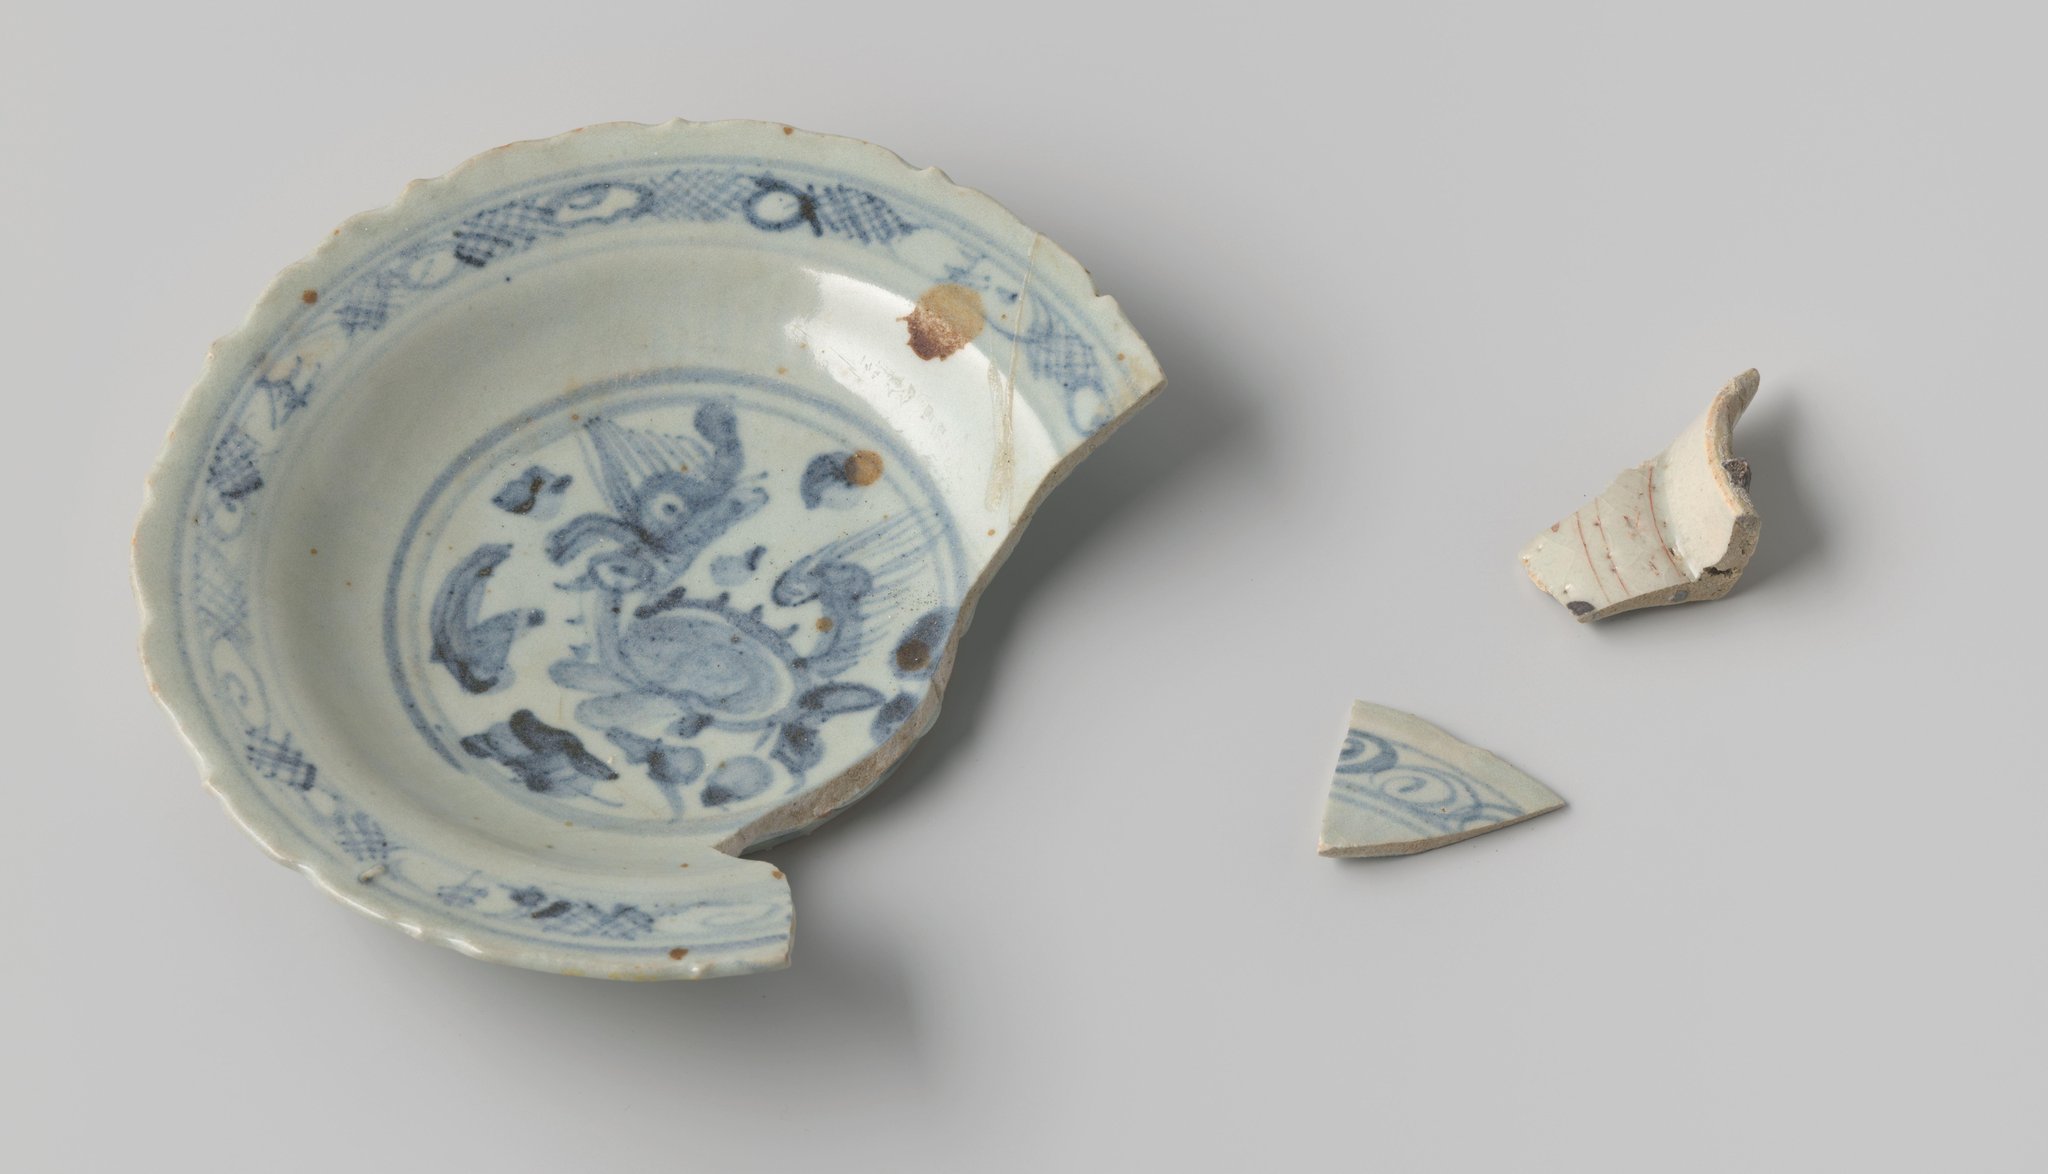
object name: plate dish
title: Scherven van borden uit V.O.C.-schip de 'Witte Leeuw'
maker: Anonymous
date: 1613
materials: porcelain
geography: shantou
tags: verenigde oostindische compagnie, sint-helena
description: A complete dish. In the centre a dancing lion very sketchily drawn encircled by a double band. The cavetto is blank. Op the lip-rim a band in which characters are sketched between criss-cross pattern.